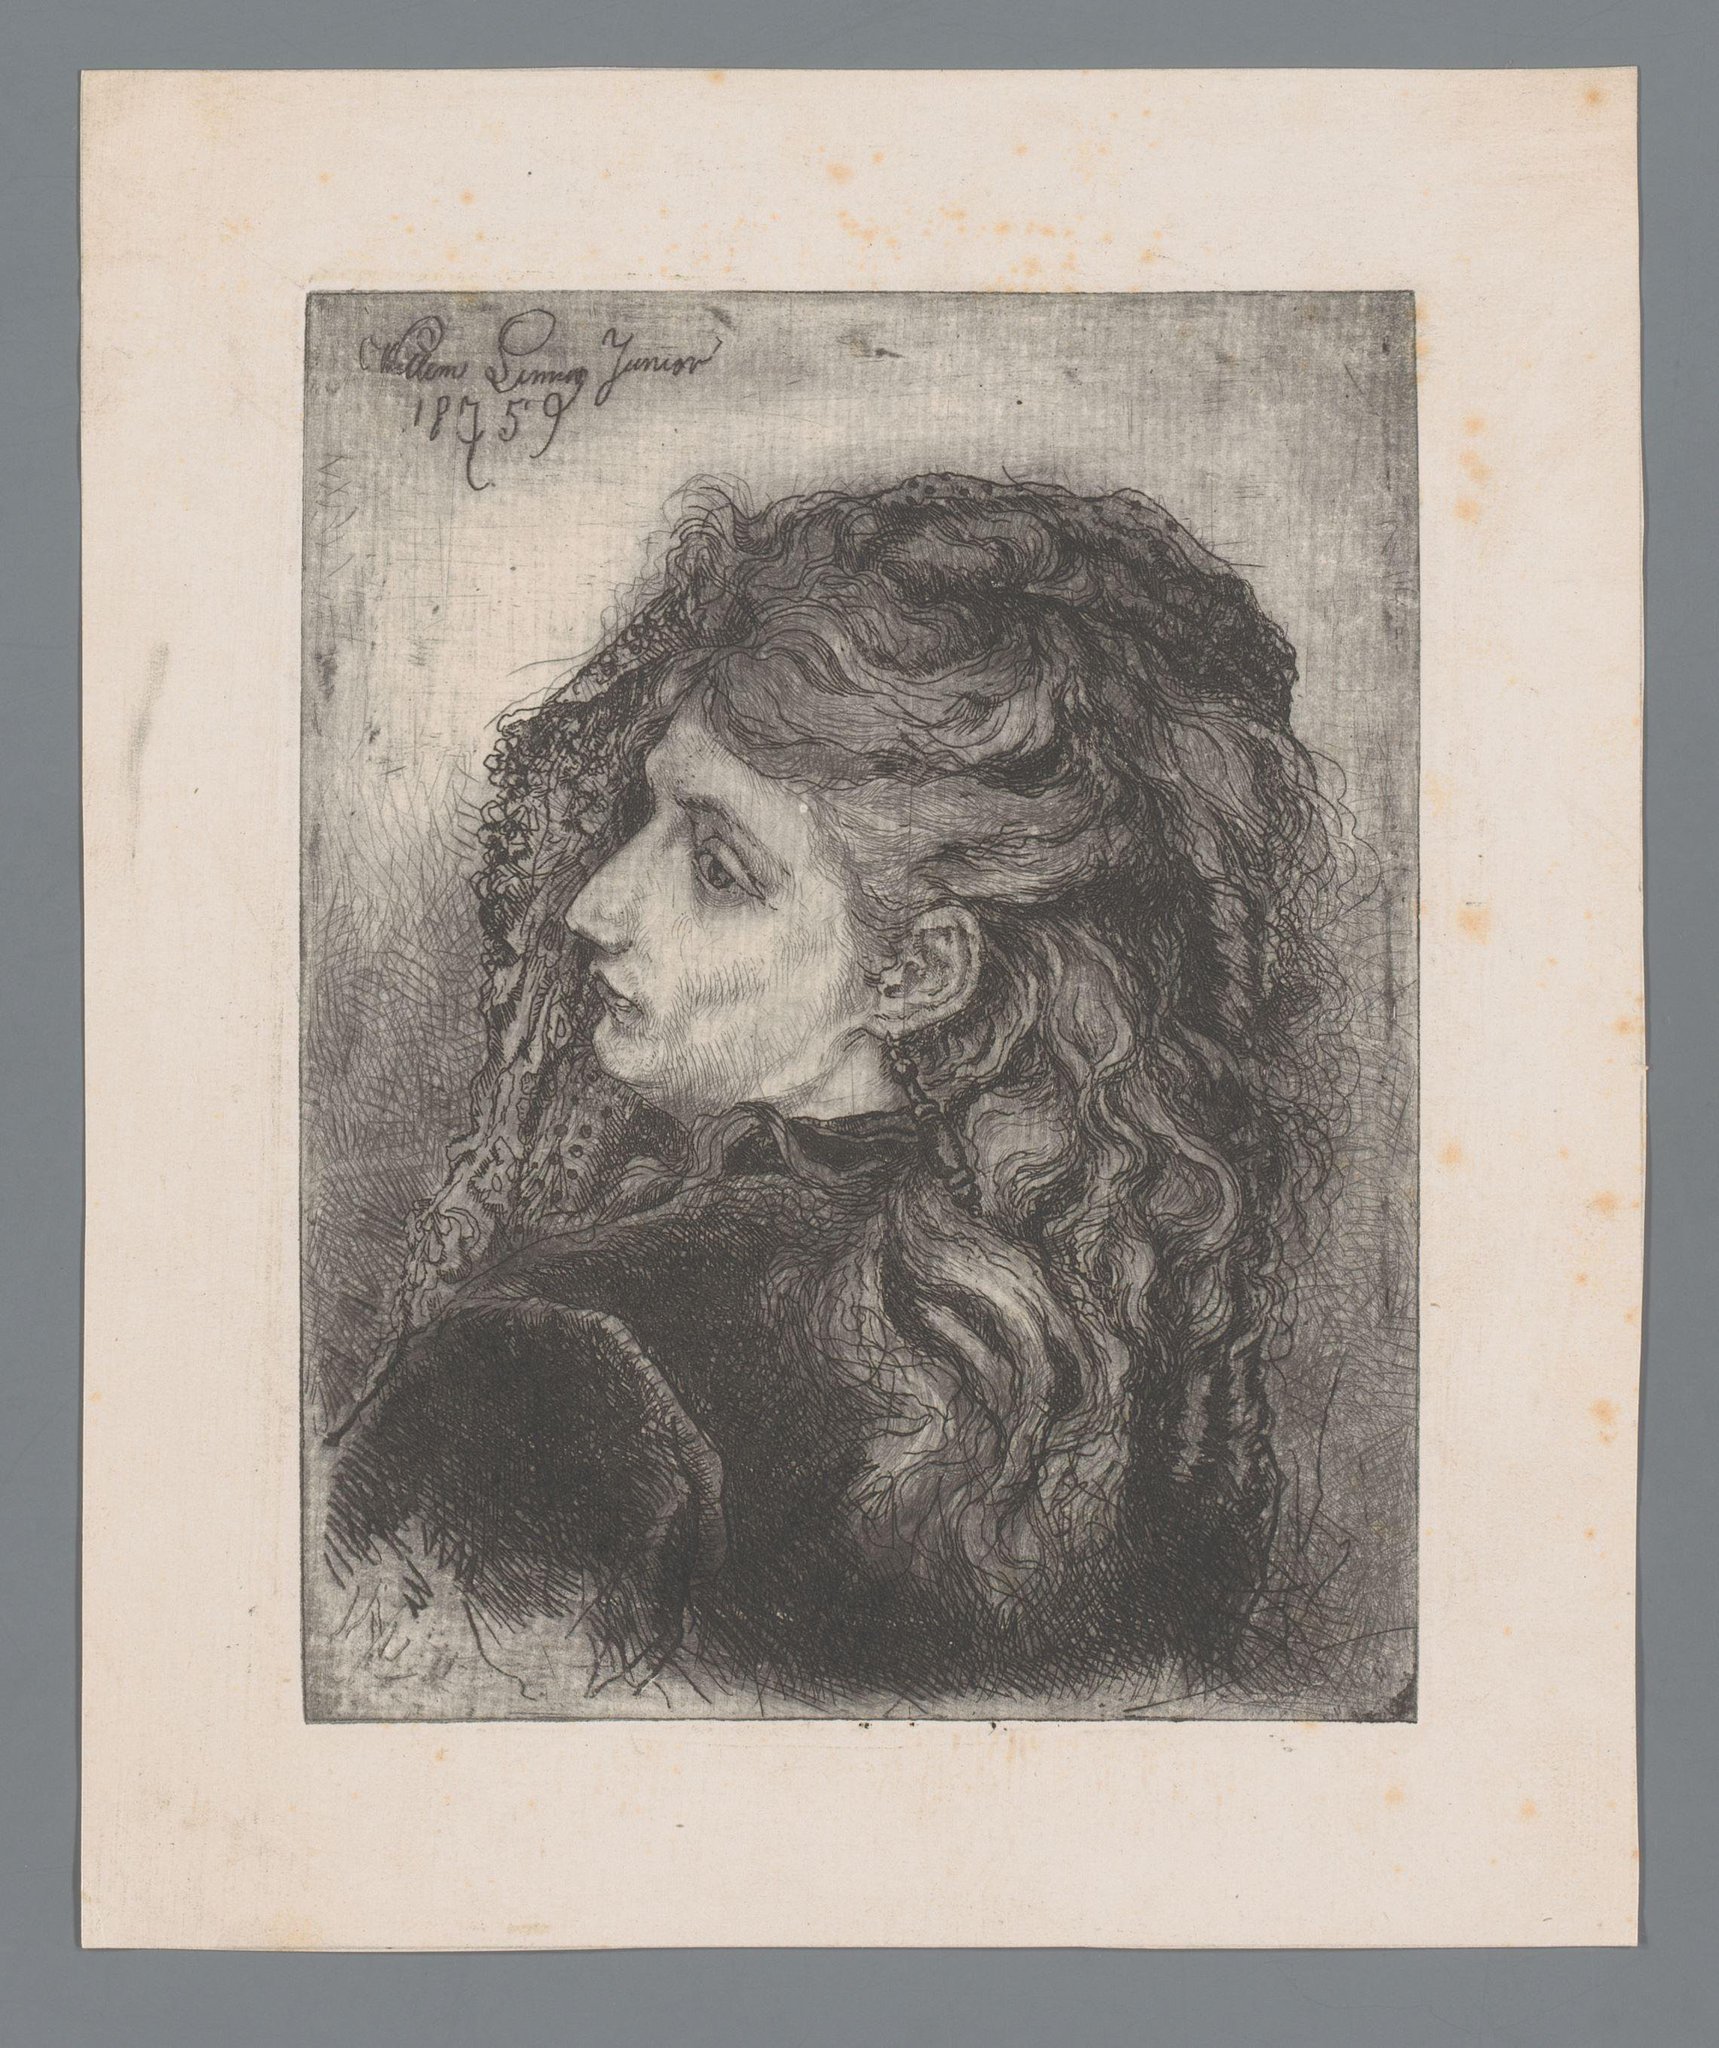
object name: print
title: Portret van een onbekende vrouw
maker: willem linnig (ii)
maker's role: print maker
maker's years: 1842-1890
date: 1875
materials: paper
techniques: etching, intaglio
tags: anonymous historical person portrayed alone - bb - woman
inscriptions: collector's mark: Lugt 2228